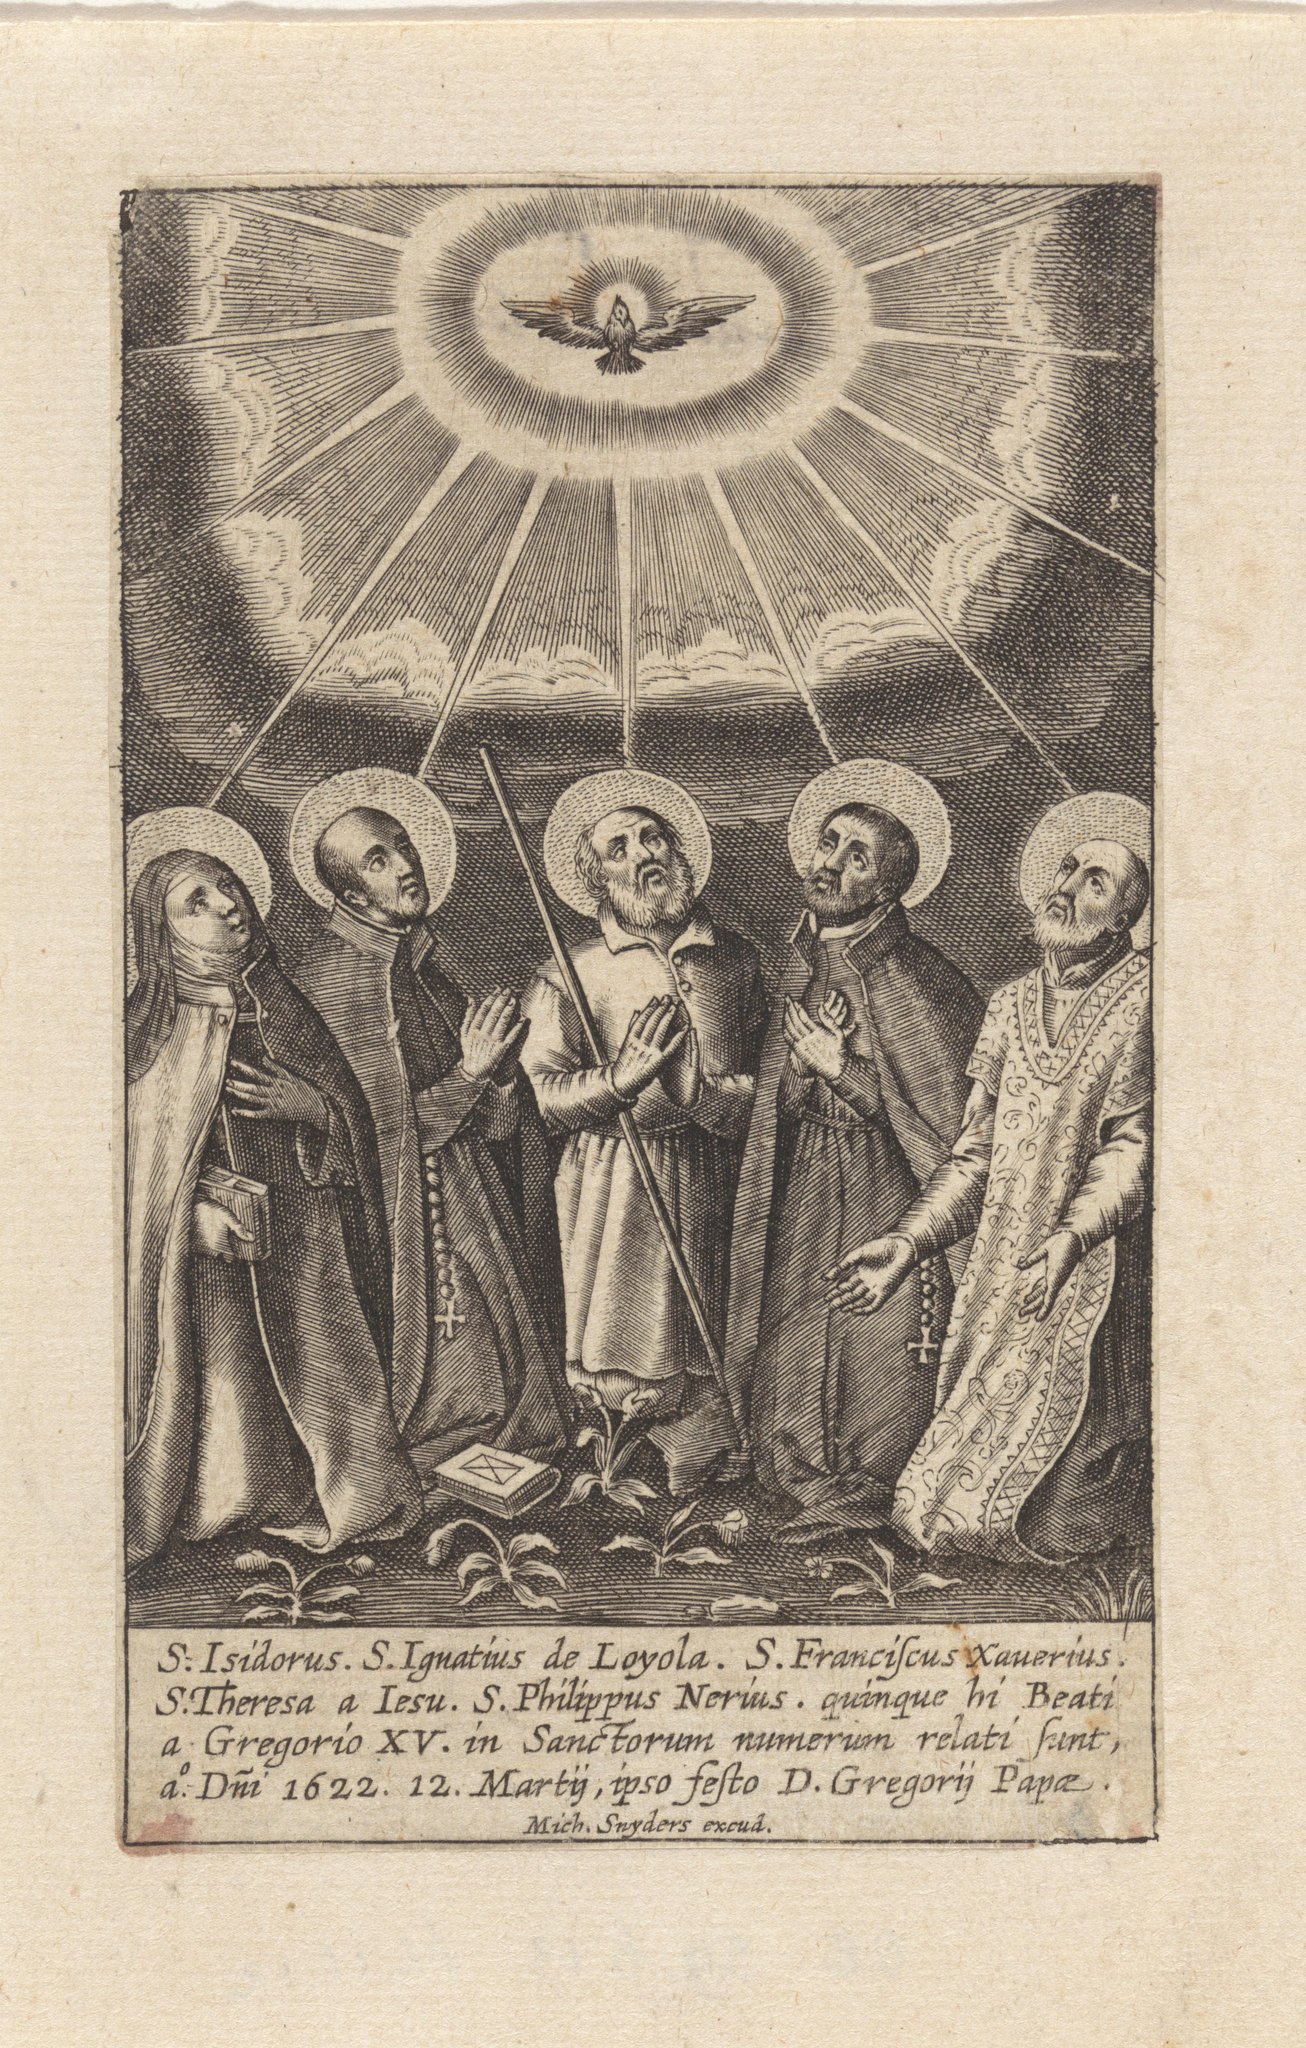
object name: print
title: Vijf heiligen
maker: michael snijders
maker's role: print maker, publisher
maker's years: 1586-1672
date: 1622-1672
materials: paper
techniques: engraving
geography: antwerp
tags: the peasant isidore the labourer (agricola) of madrid; possible attributes: agricultural implements, e.g.: plough, sickle, the foundress of the reformed (discalced) carmelites, t(h)eres(i)a of avila; possible attributes: angel, arrow, dove, heart (flaming or pierced by an arrow), the founder of the jesuit order, ignatius of loyola; possible attributes: book (with 'ad majorem dei gloriam'), demon, dragon under feet, flames, flaming heart, globe, ihs monogram, skull (with crown), tears in eyes, torch, the jesuit missionary francis xavier; possible attributes: cross, crucifix, flaming heart, indian, lily, torch, the founder of the congregation of the oratory (oratorians) philip neri; possible attributes: lily, rosary, holy ghost represented as a dove (in flames)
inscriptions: collector's mark: Lugt 2228, inscription: ‘P. Mariette 1684’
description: De heiligen Isidorus, Ignatius van Loyola, Franciscus Xaverius, Theresa van Avila en Philippus Nerius zitten geknield op de grond en kijken in aanbidding omhoog naar de Heilige Geest, voorgesteld als duif. Onder de prent een verklarende tekst, met een referentie aan hun canonisatie door paus Gregorius XV op 12 maart 1622.